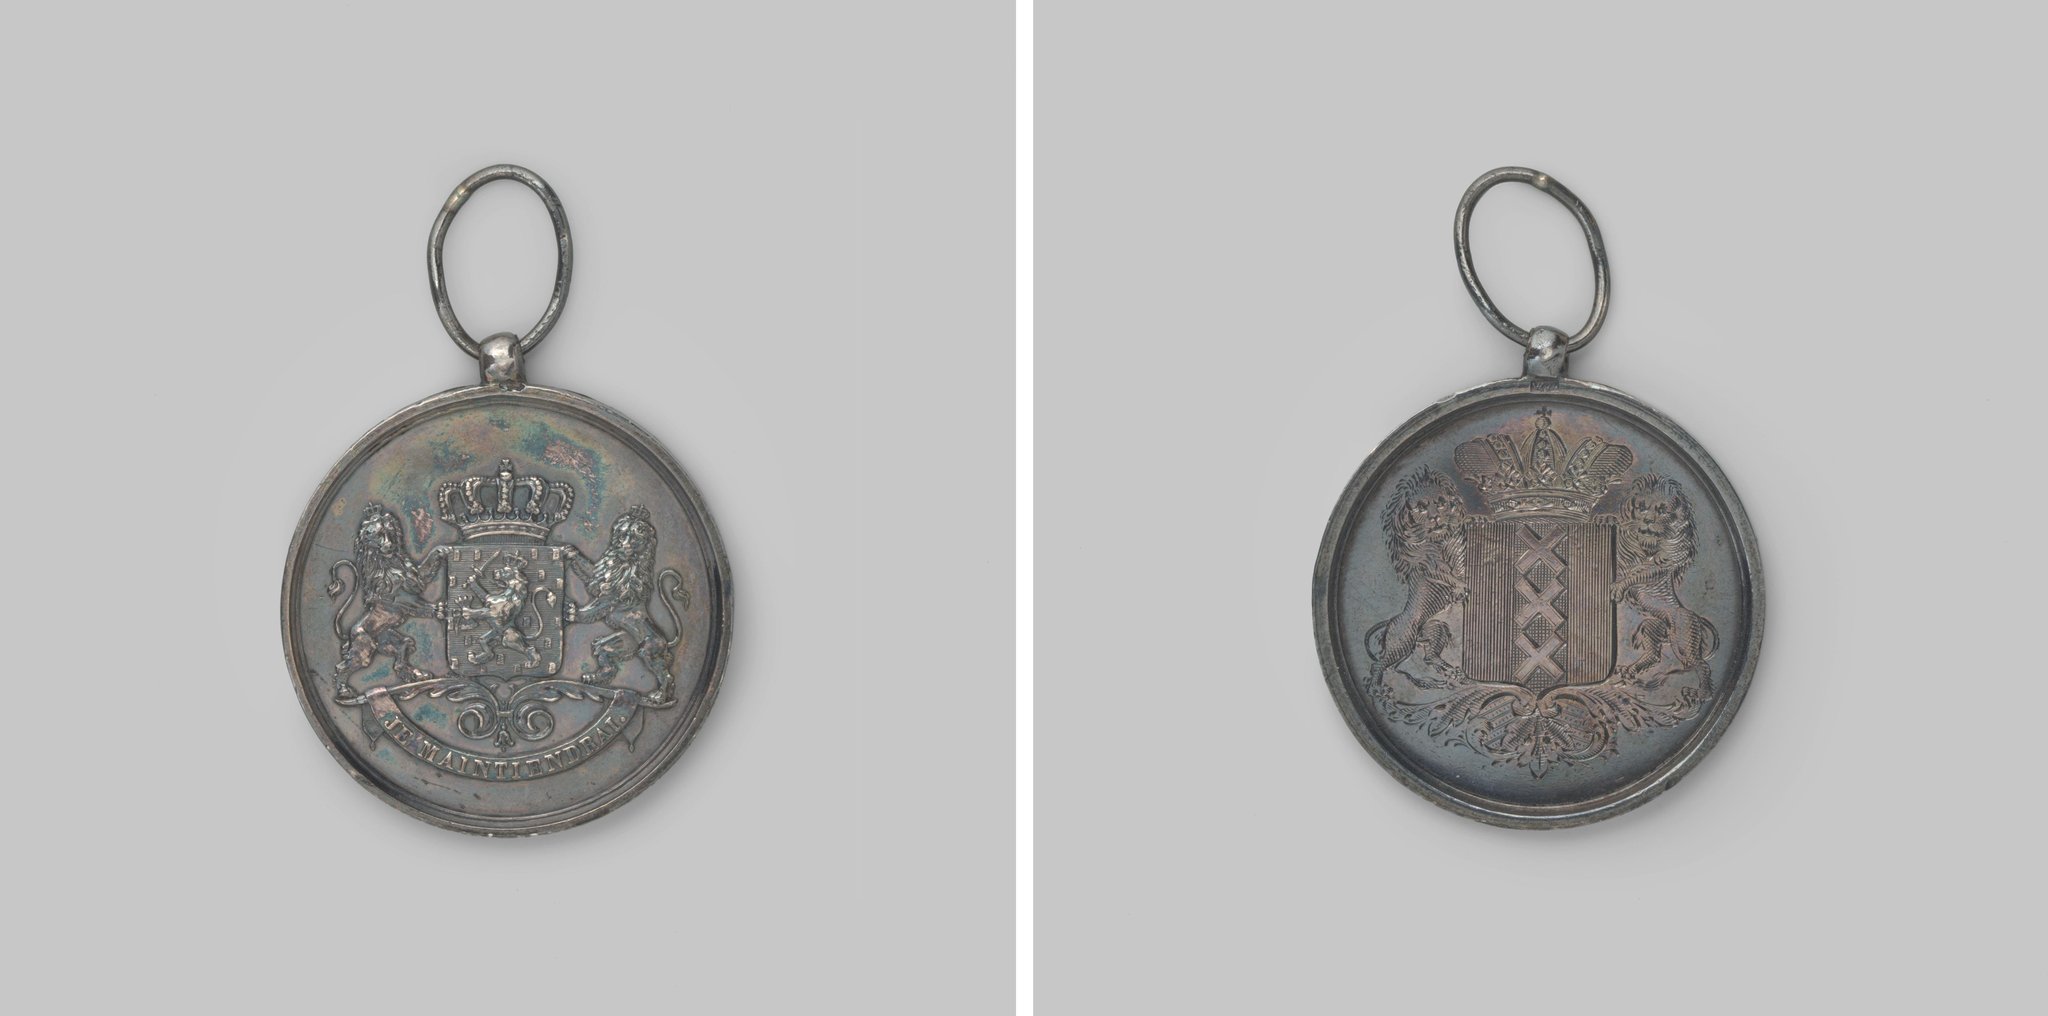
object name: history medal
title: Burgemeesterspenning Gemeente Amsterdam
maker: david van der kellen (1804-1879)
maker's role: die cutter, draughtsman, print maker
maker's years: 1804-1879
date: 1852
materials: silver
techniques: striking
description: Penning van zilver met aan de voorzijde Gekroond Rijkswapen met dragers op loofwerk met banderol. Op de keerzijde met gravure gekroond wapenschild van Amsterdam met dragers op loofwerk.